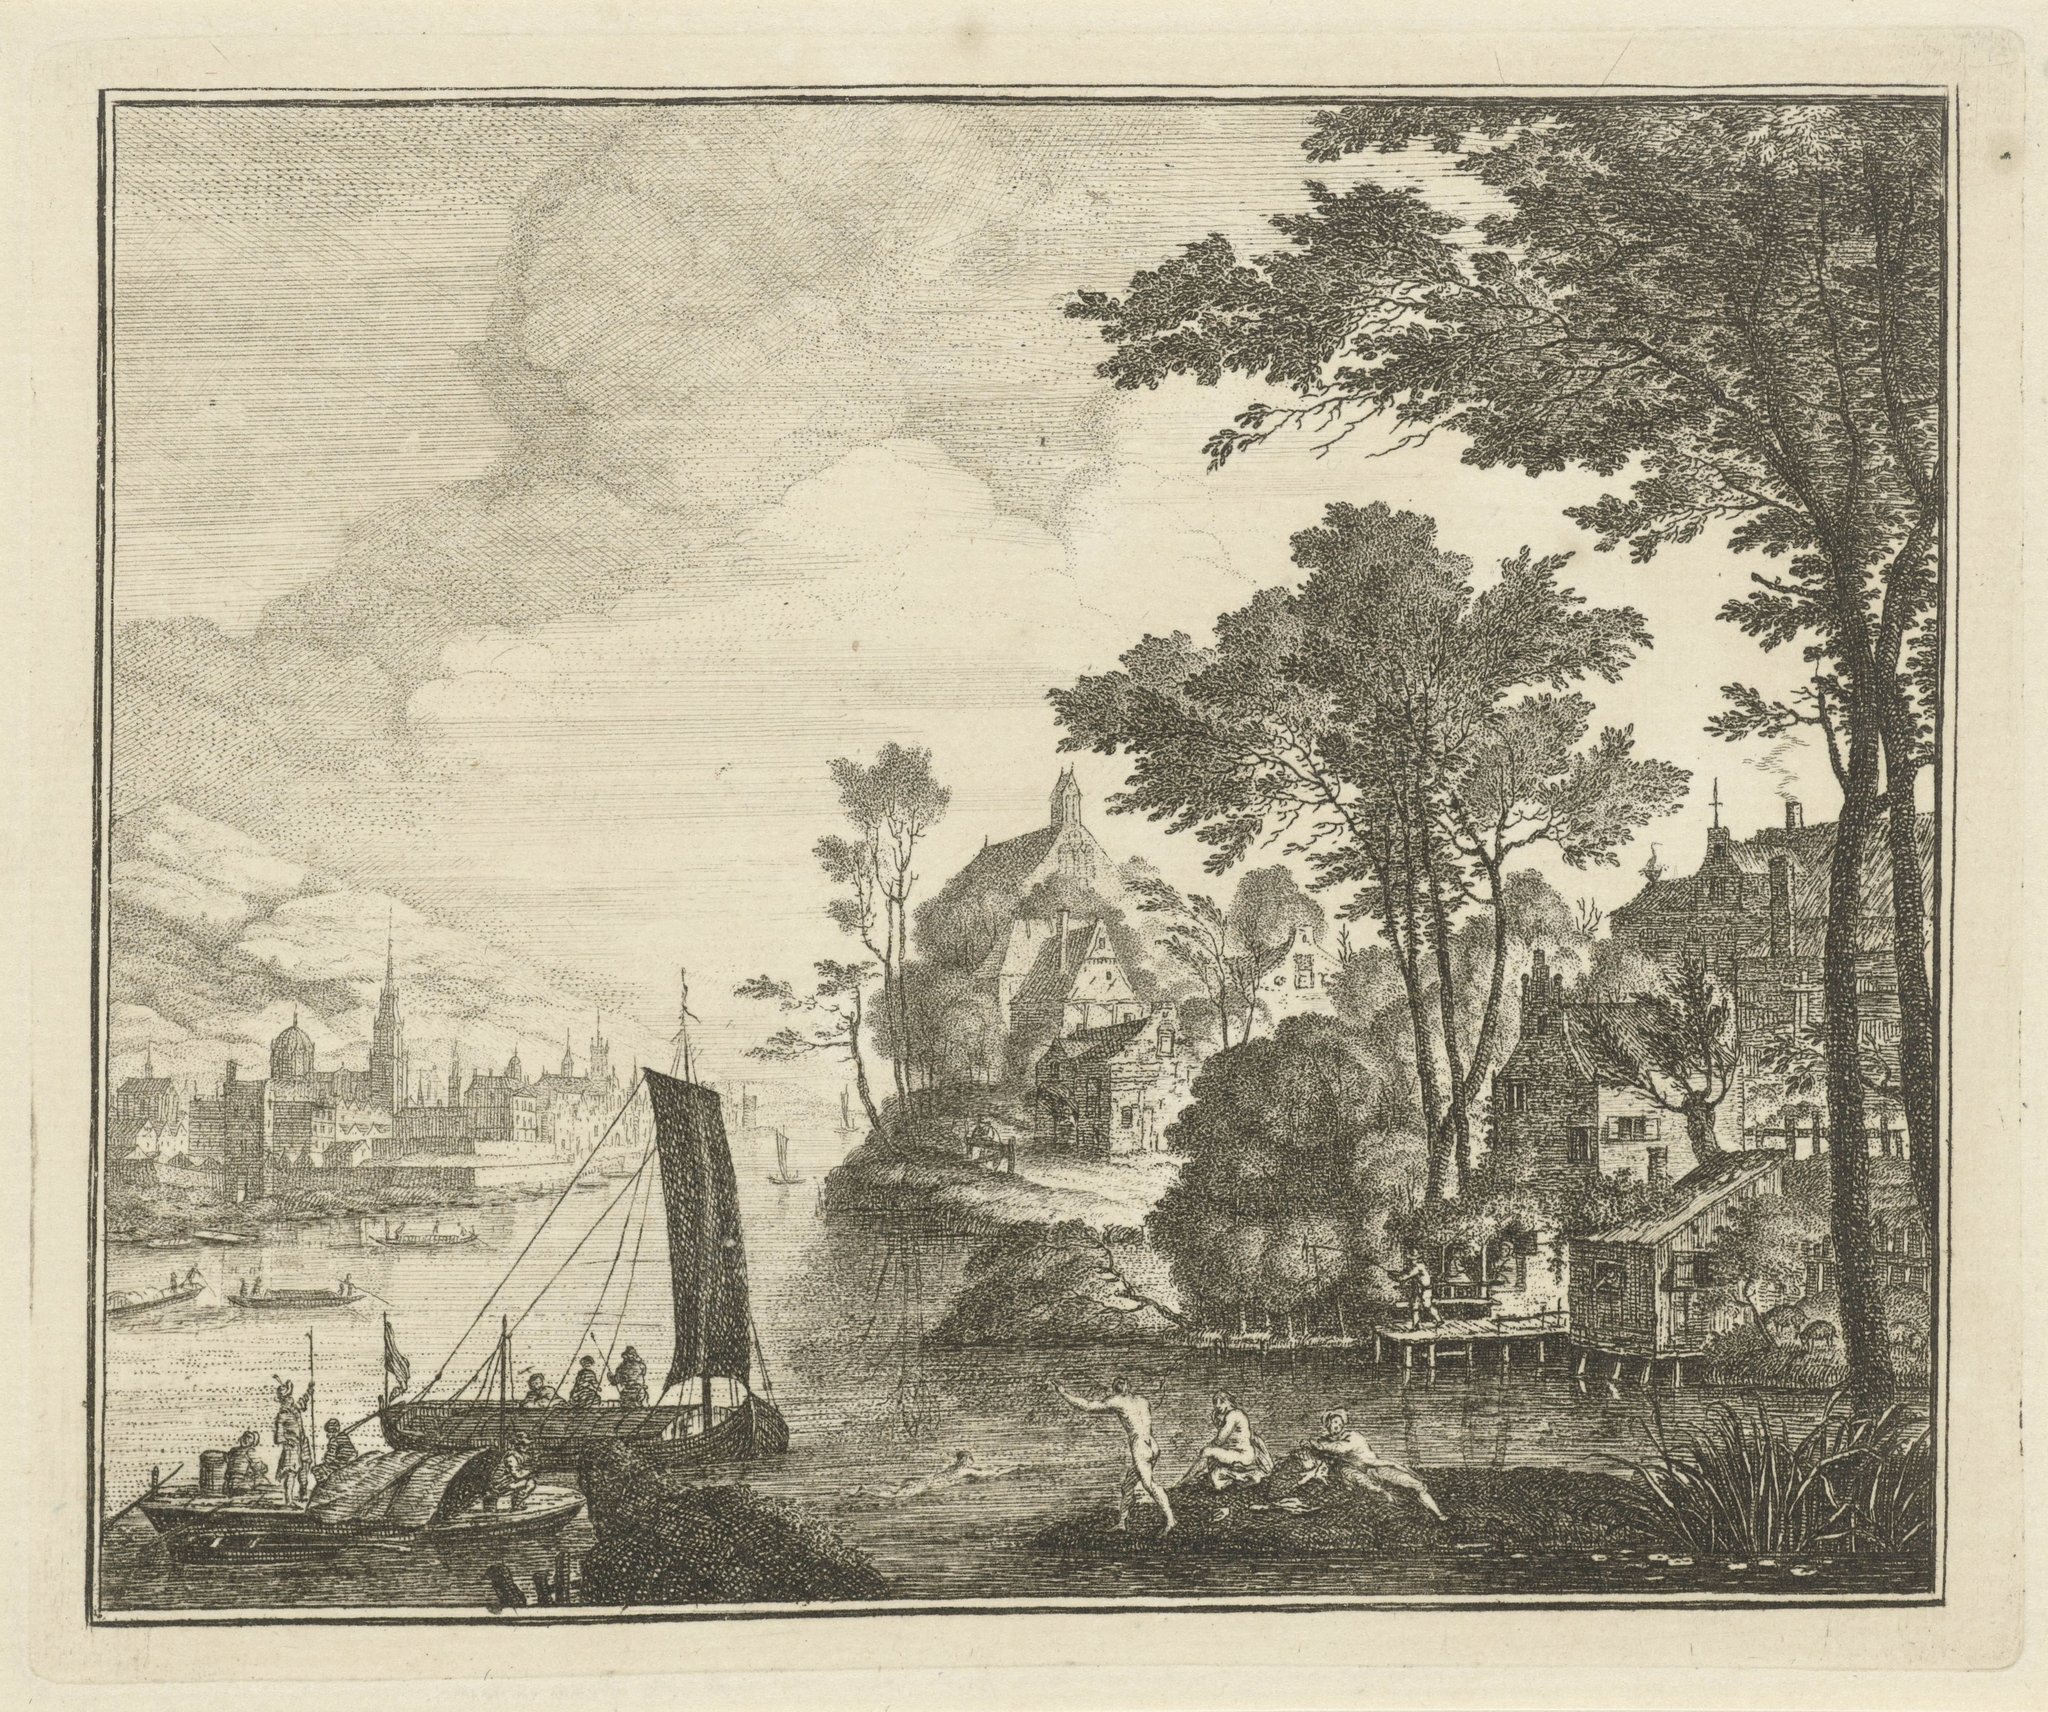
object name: print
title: Rivierlandschap met zwemmers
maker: gerard melder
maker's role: painter, print maker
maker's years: 1693-1754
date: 1703-1754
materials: paper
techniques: etching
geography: utrecht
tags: water course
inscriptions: collector's mark: Lugt 2228